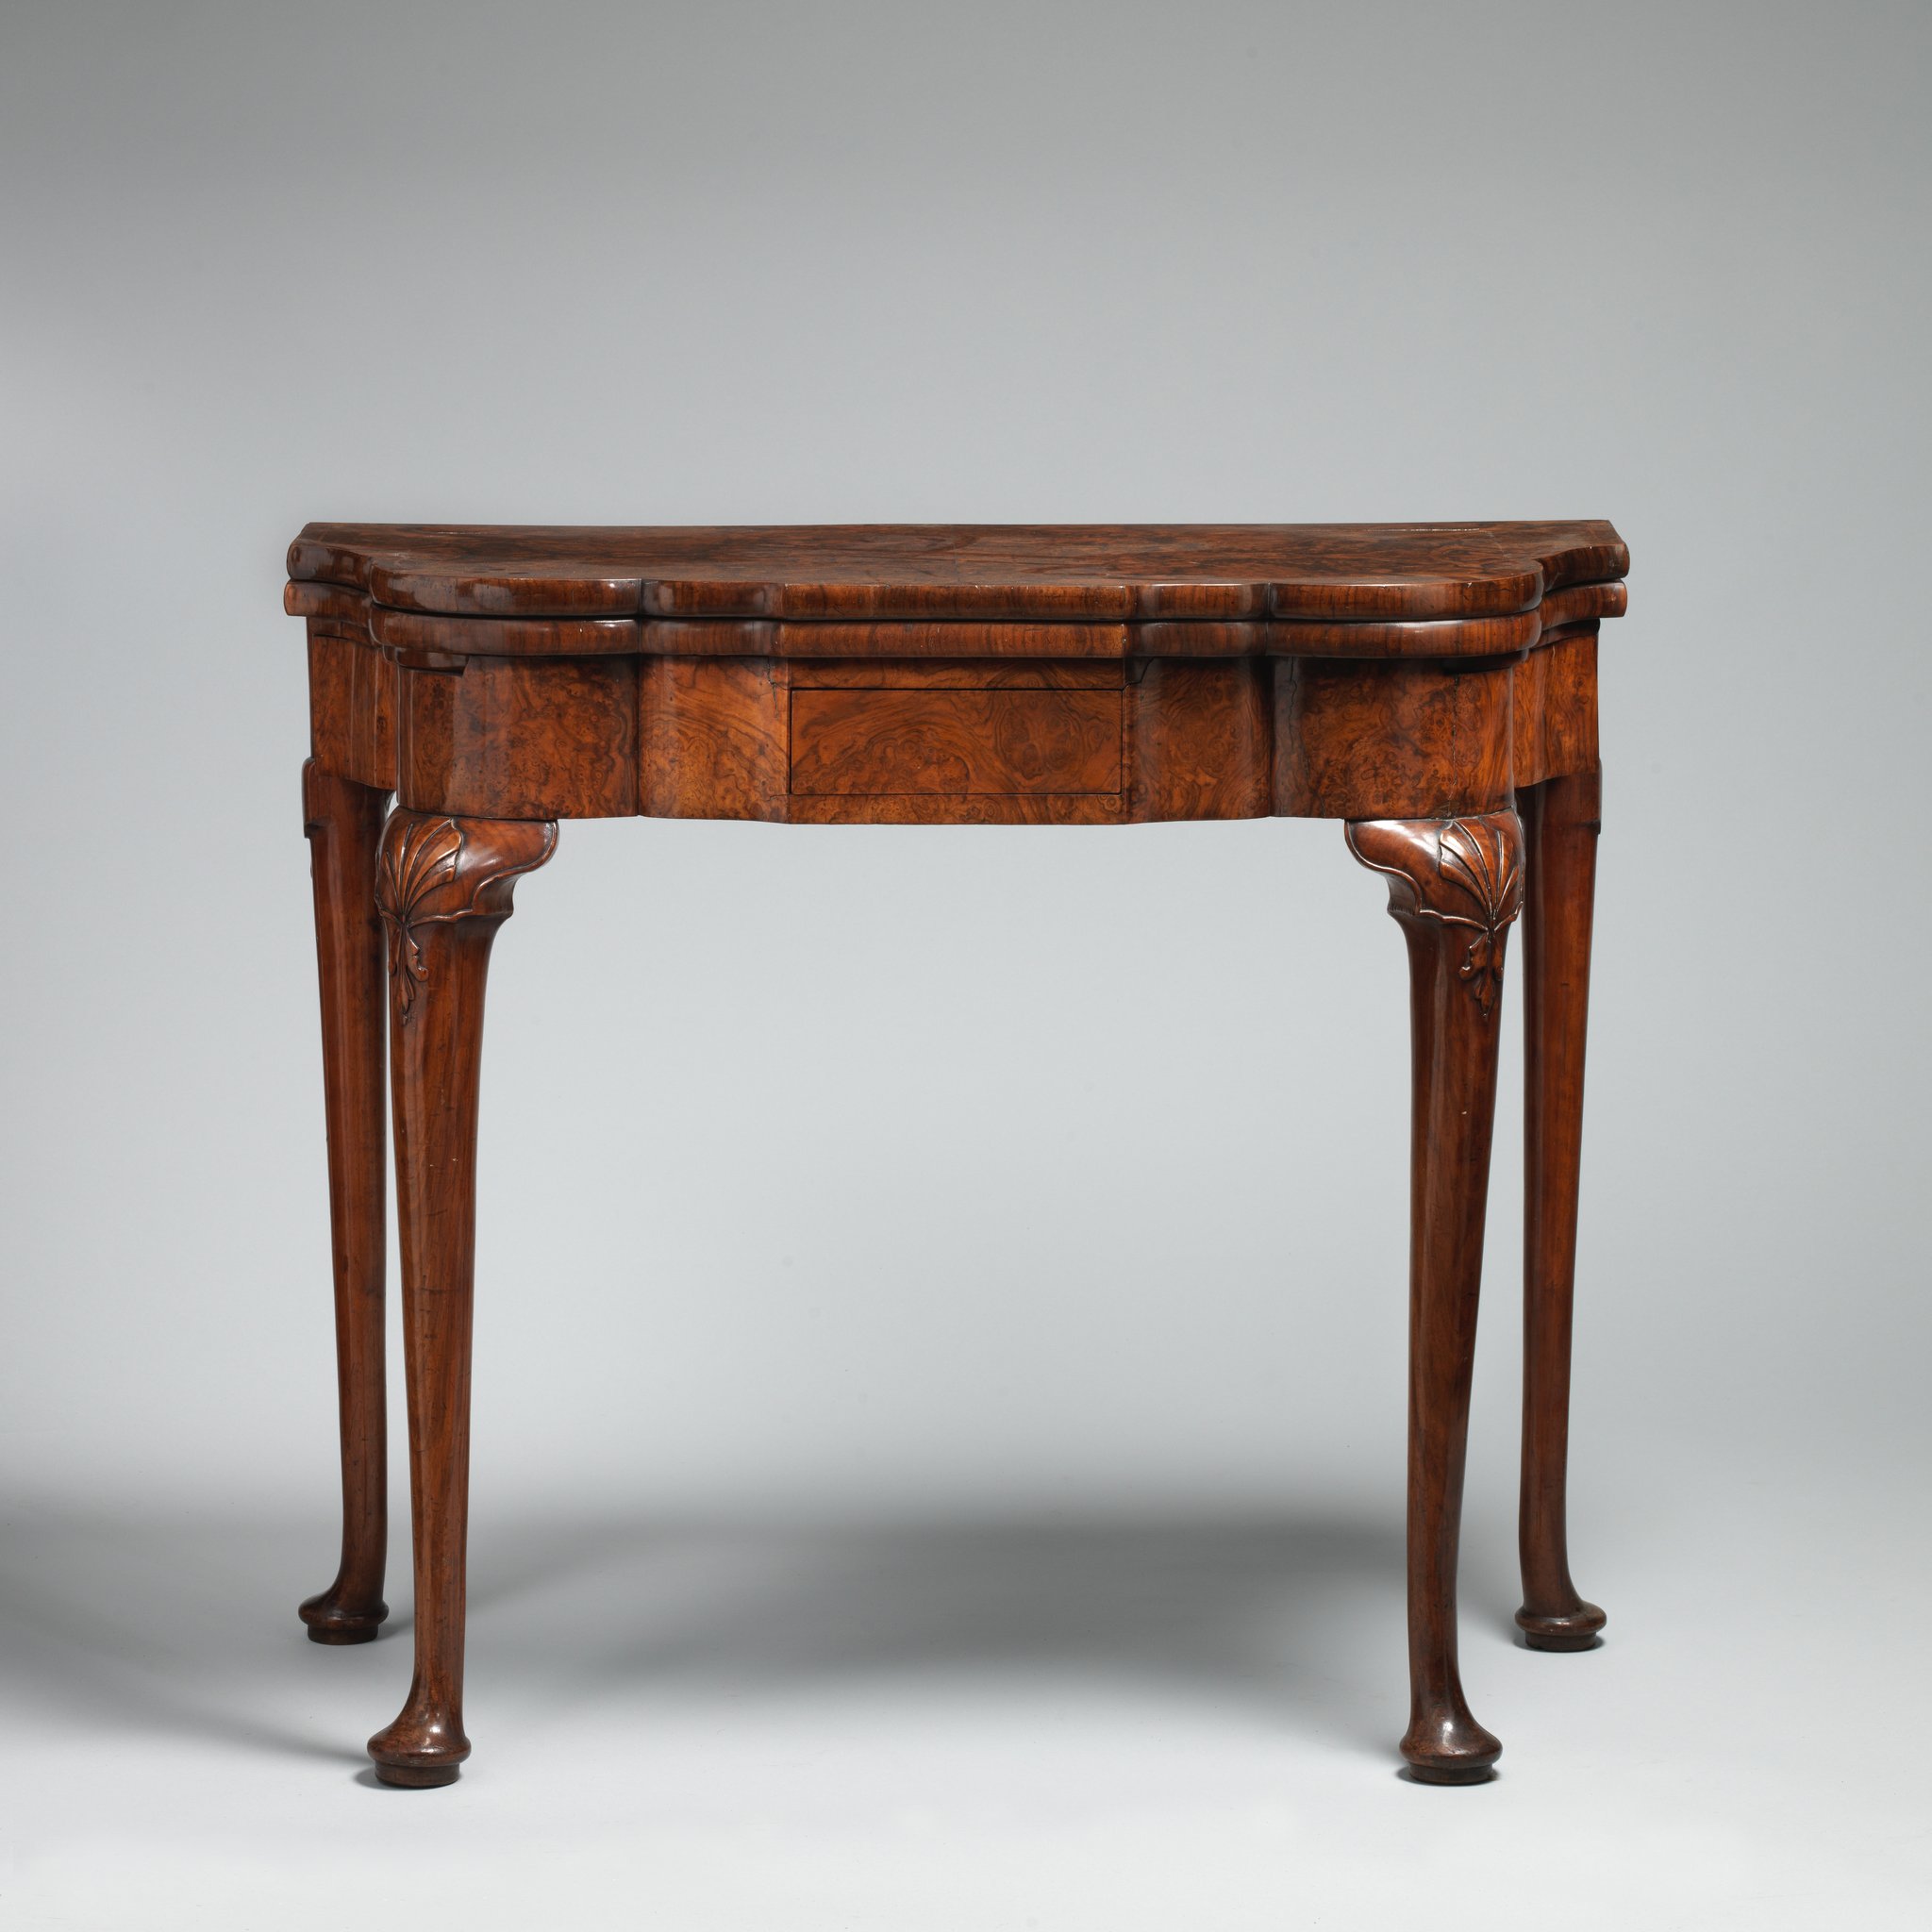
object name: card table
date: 1725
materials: wood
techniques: veneering